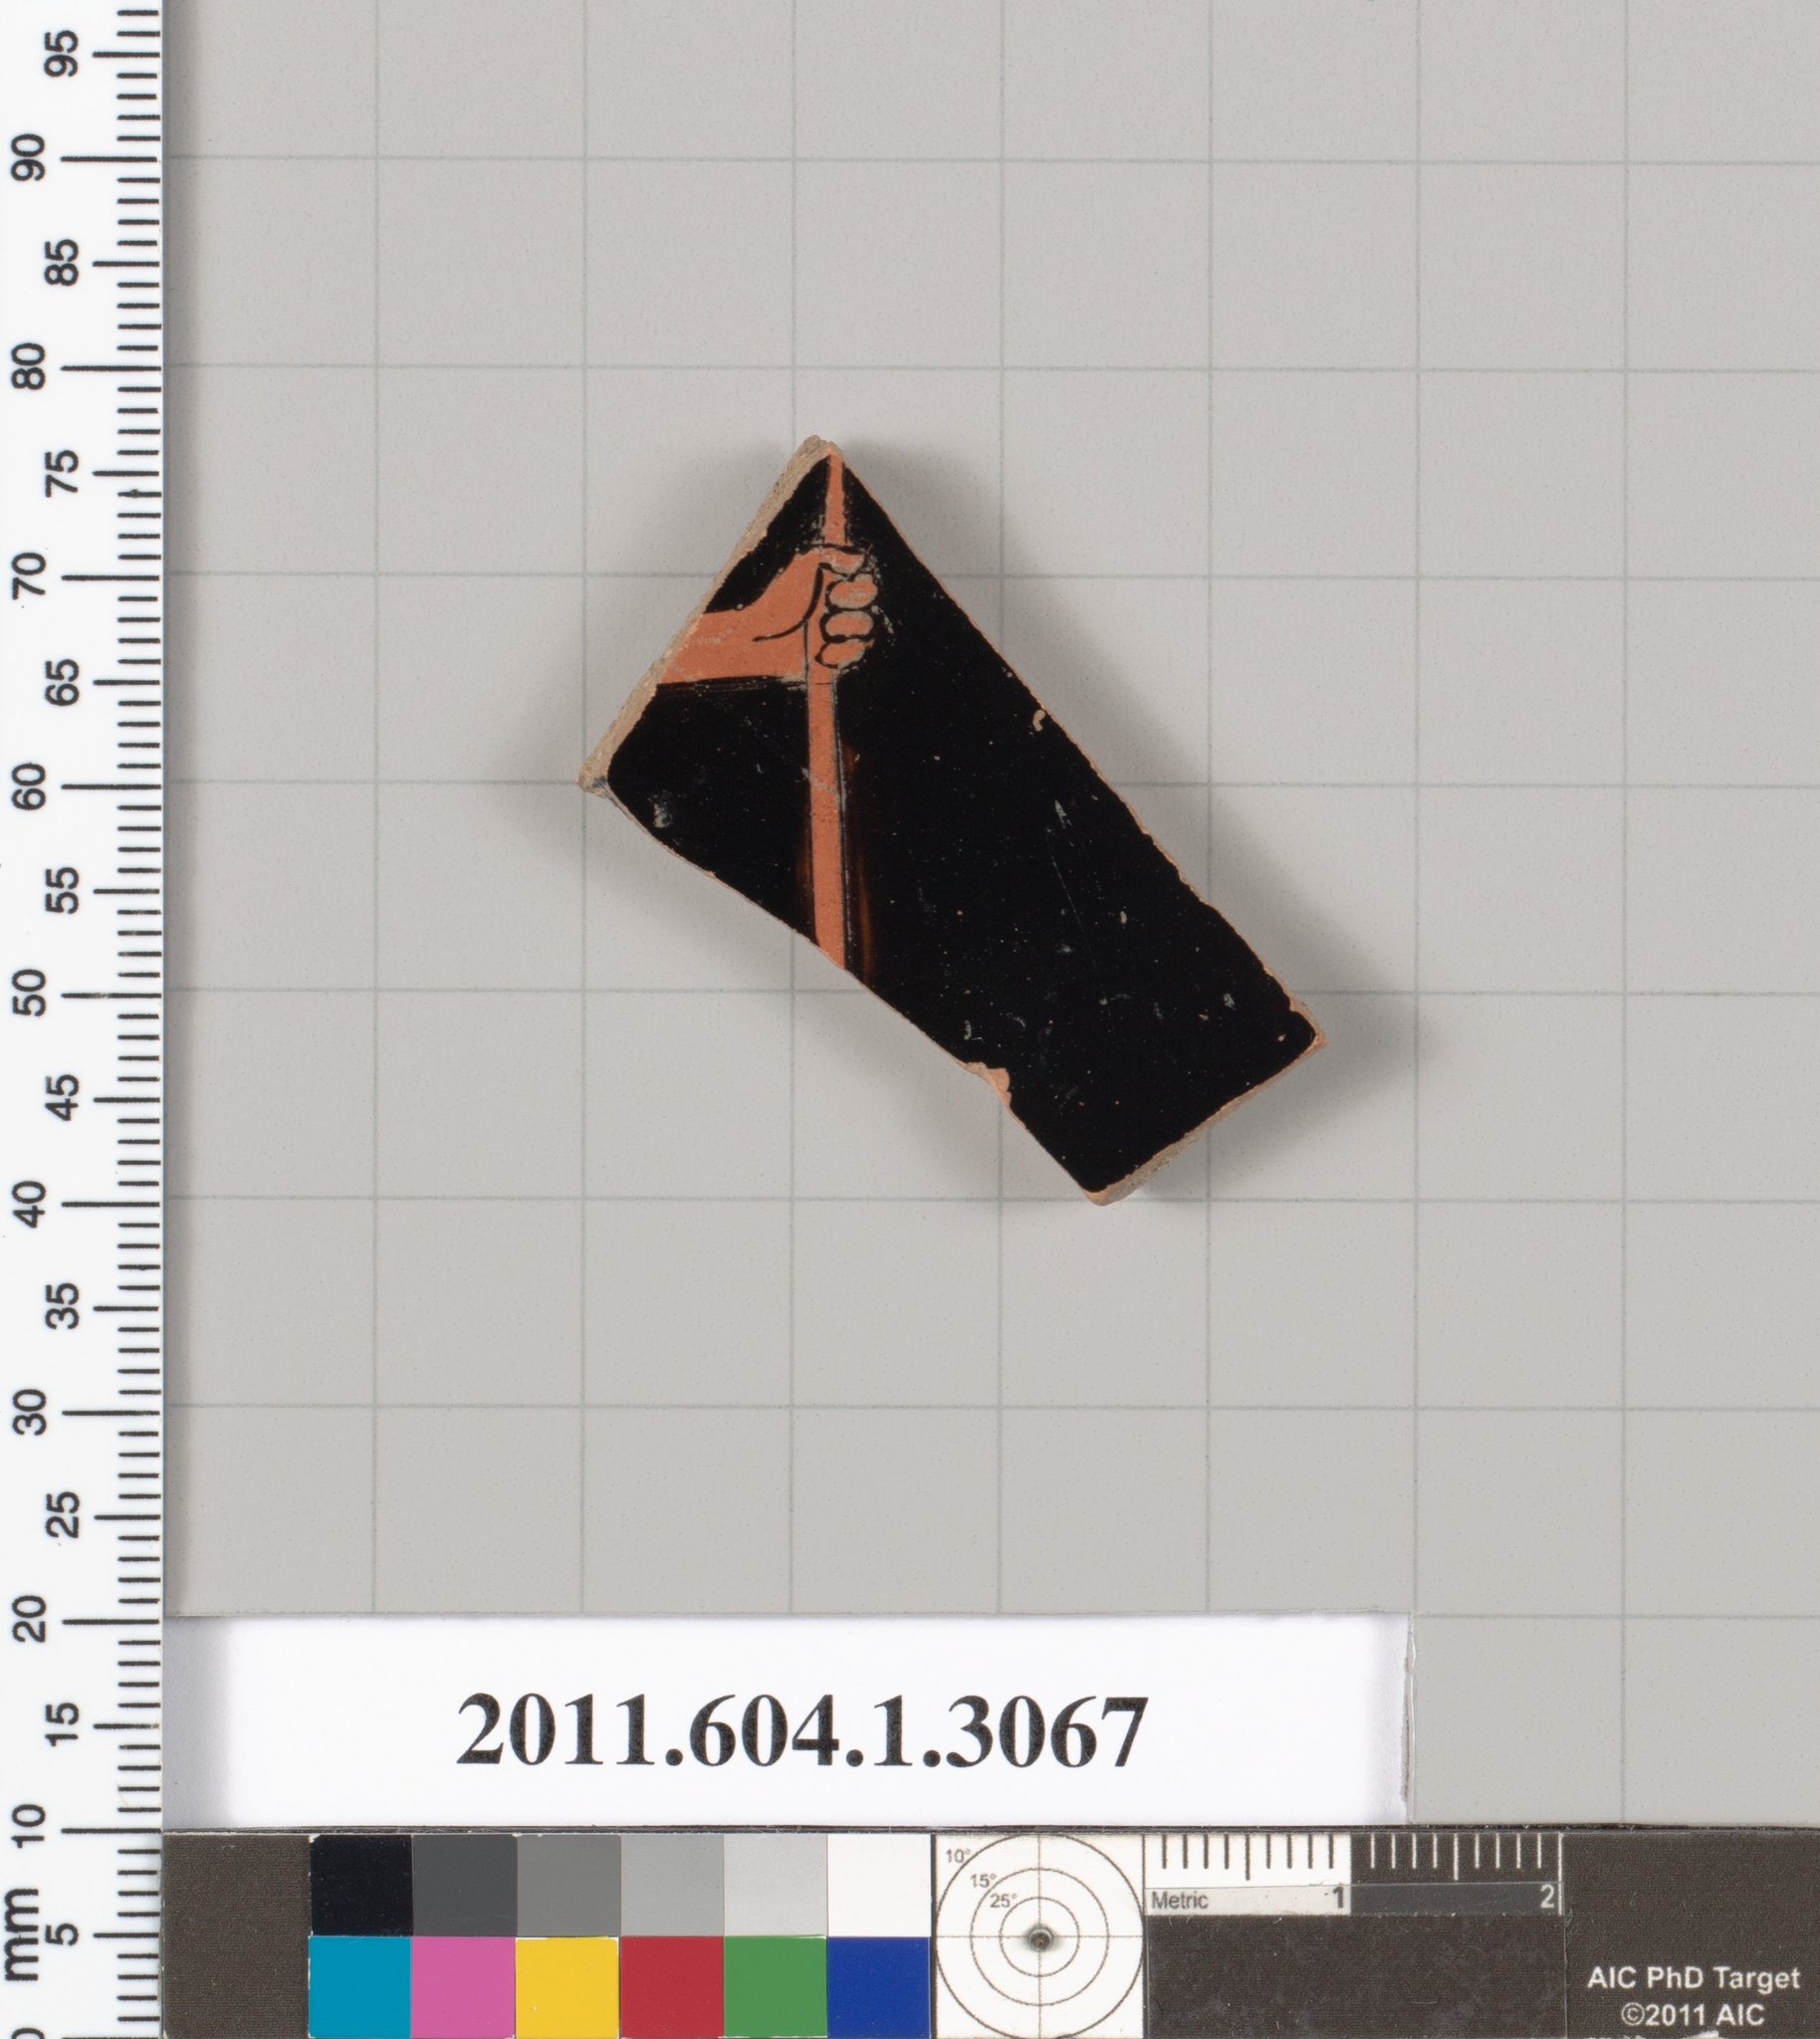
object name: kylix fragment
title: Terracotta fragment of a kylix (drinking cup)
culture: greek, attic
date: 490-480 BCE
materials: terracotta